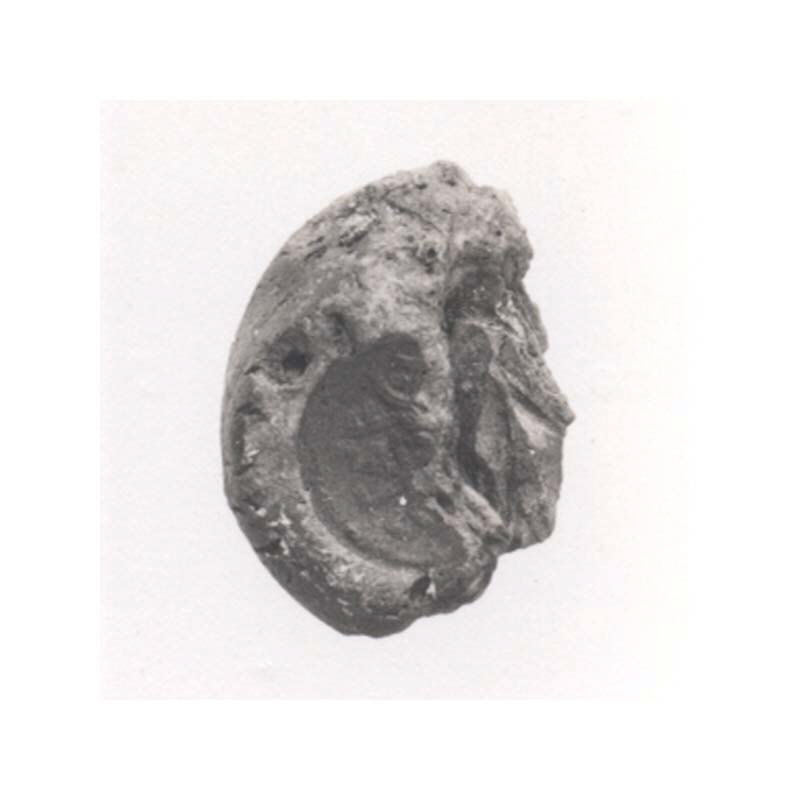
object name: sealing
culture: sasanian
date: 601-700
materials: clay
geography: iran